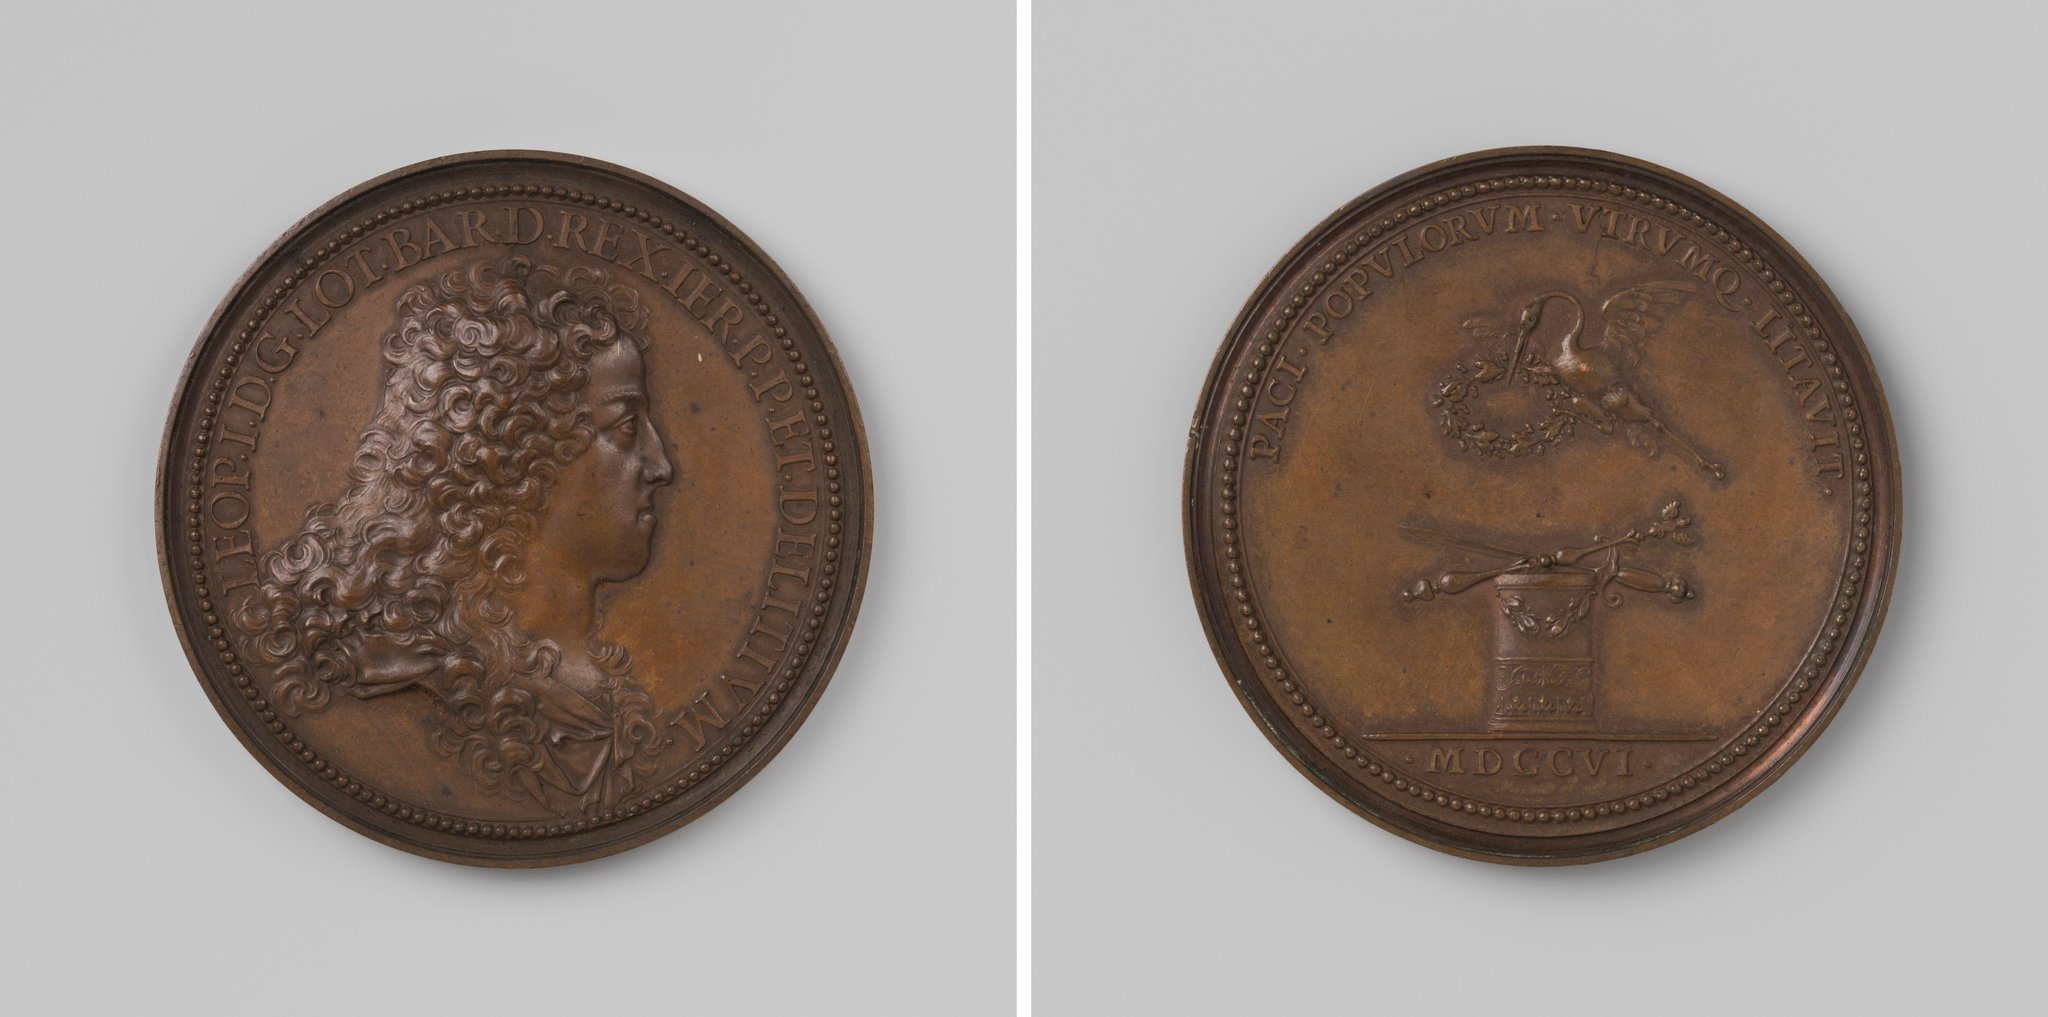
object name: medal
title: Leopold I, hertog van Lotharingen en Bar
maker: ferdinand de saint urbain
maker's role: graveur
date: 1706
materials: bronze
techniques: striking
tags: hertog, leopold i (hertog van lotharingen en bar)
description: Bronzen penning. Voorzijde: borststuk man binnen omschrift. Keerzijde: gekruiste scepter en degen, daarboven vliegende ooievaar met eikenkrans in bek binnen omschrift; afsnede: jaartal